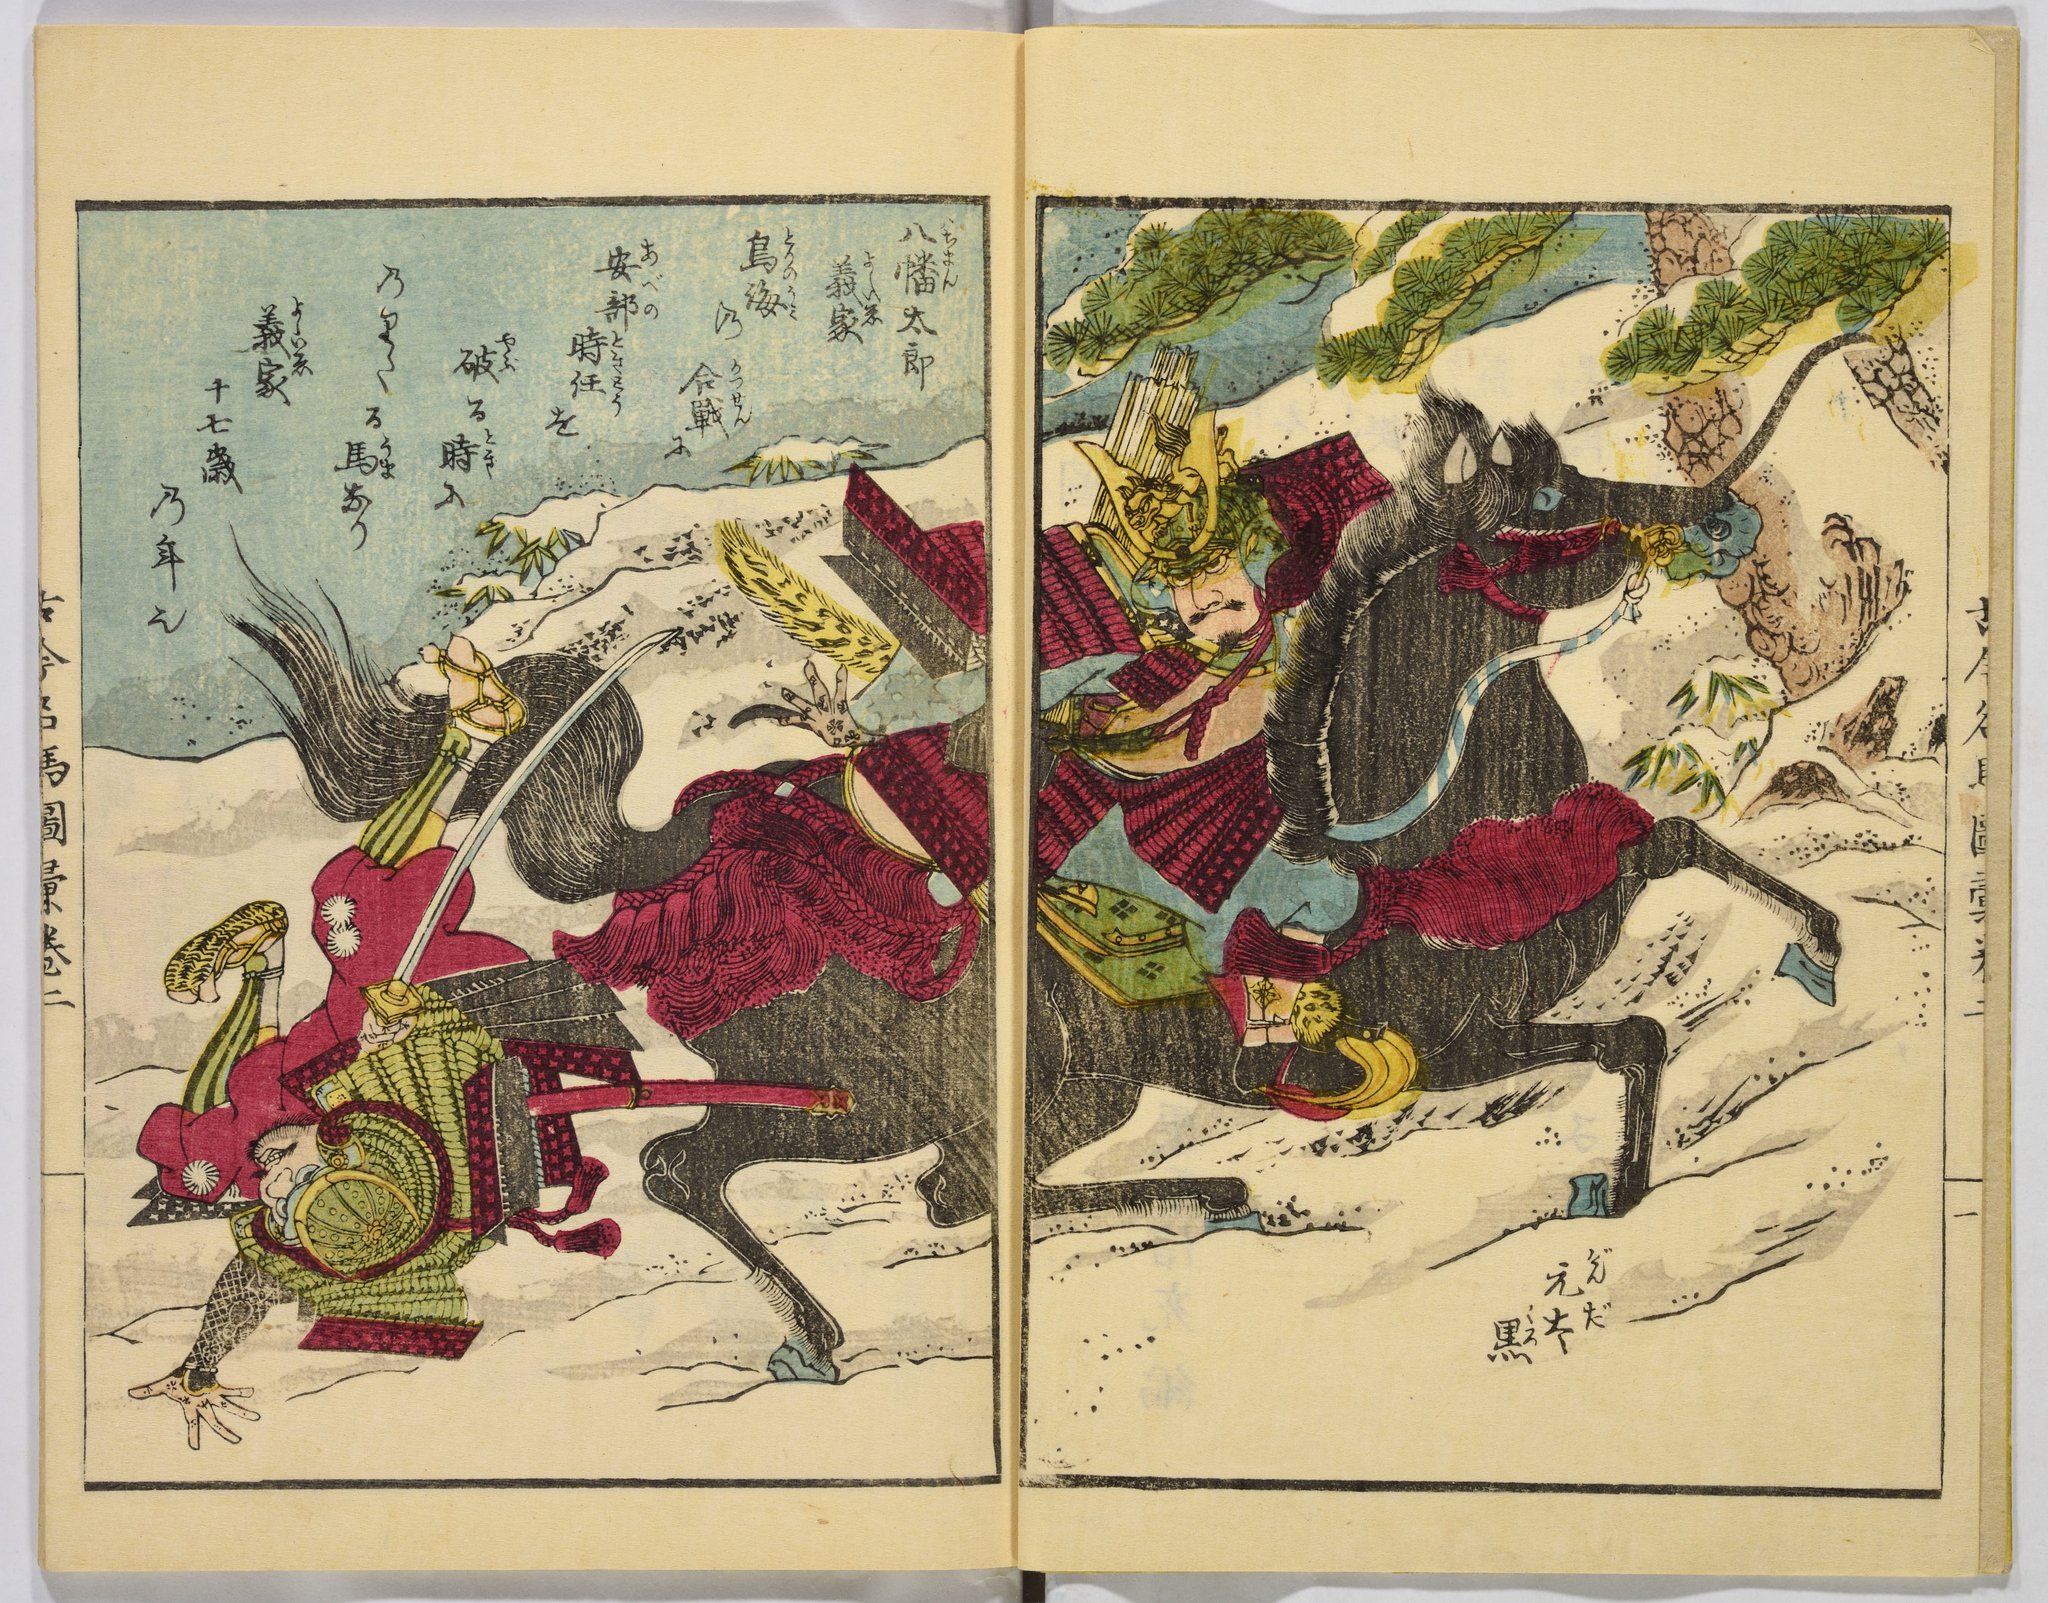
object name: illustrated book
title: Pictures of Famous Horses Yesterday and Today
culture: japanese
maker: unidentified artist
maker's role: artist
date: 1615-1868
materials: ink, paper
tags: men,horses